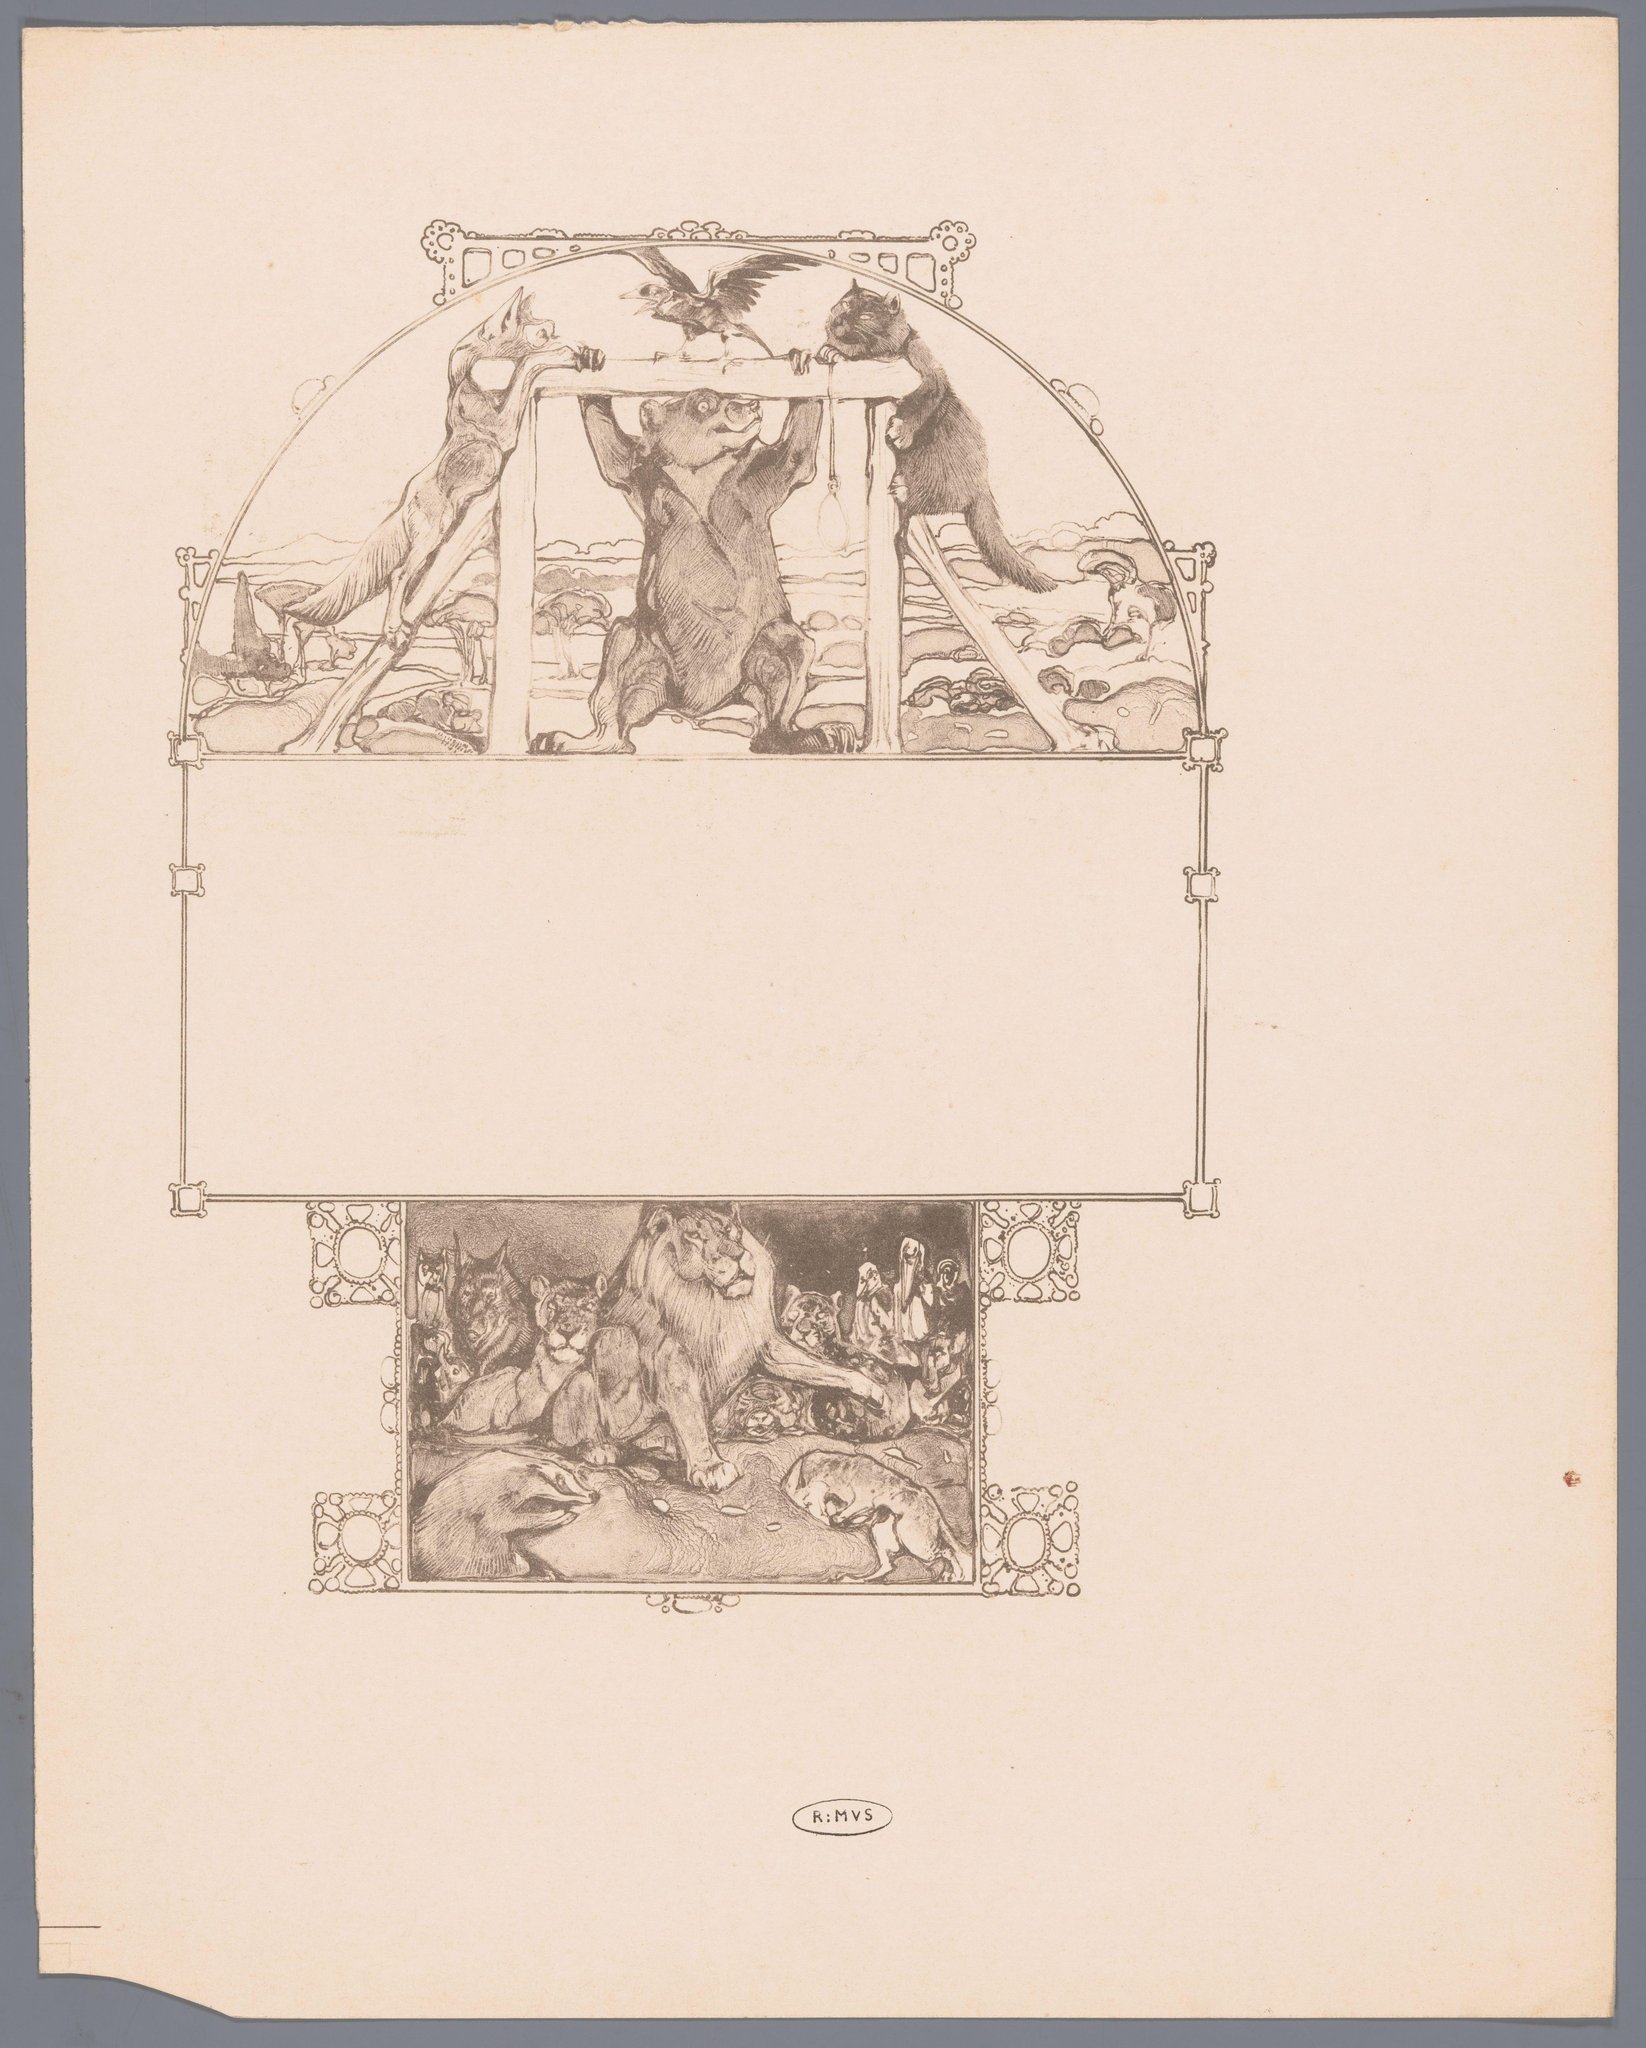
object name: print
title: Vos (Reinaert), beer (Bruun), kat (Tybeert) en raaf (Tiecelijn) bij galg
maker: bernard willem wierink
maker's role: draughtsman, print maker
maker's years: 1856-1939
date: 1910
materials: paper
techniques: lithograph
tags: fable of reynard the fox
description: Ontwerp voor: Streuvels, Stijn (Frank Lateur). Reinaert de Vos naar verschillende uitgaven van het middeleeuwsche epos. Amsterdam: L.J. Veen, 1910.